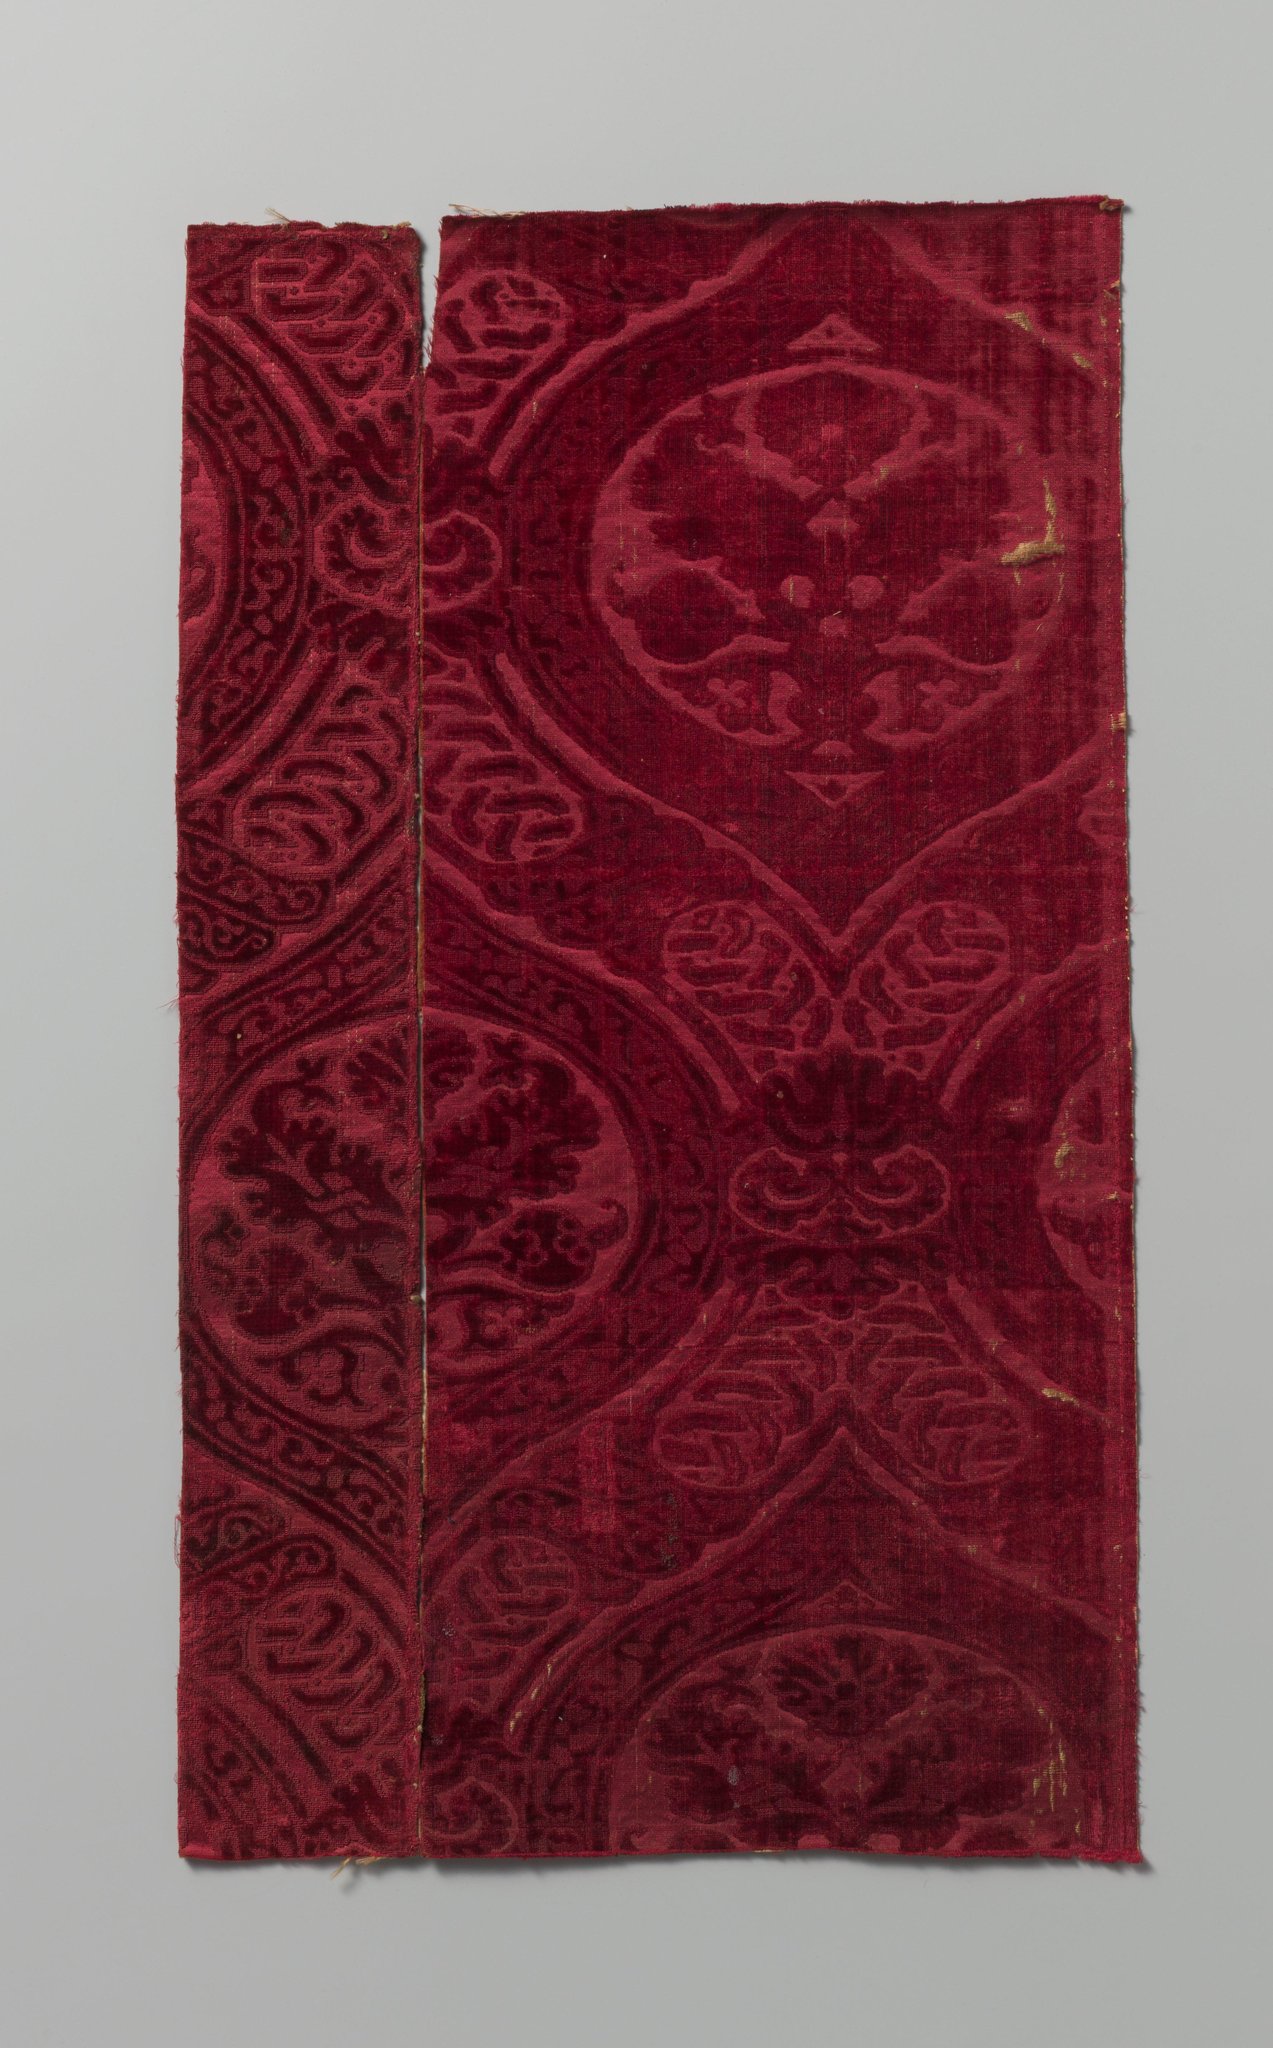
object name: zijdefluweel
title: Fragment donkerrode zijdefluweel met uitsparingen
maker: Anonymous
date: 1500-1599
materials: silk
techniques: velvet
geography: genoa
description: Fragment (2 aan elkaar geplakt) donkerrode fluweel met patroon van dubbel omkranste bloem, waarvan de buitenste kransen zijn samengeknoopt.